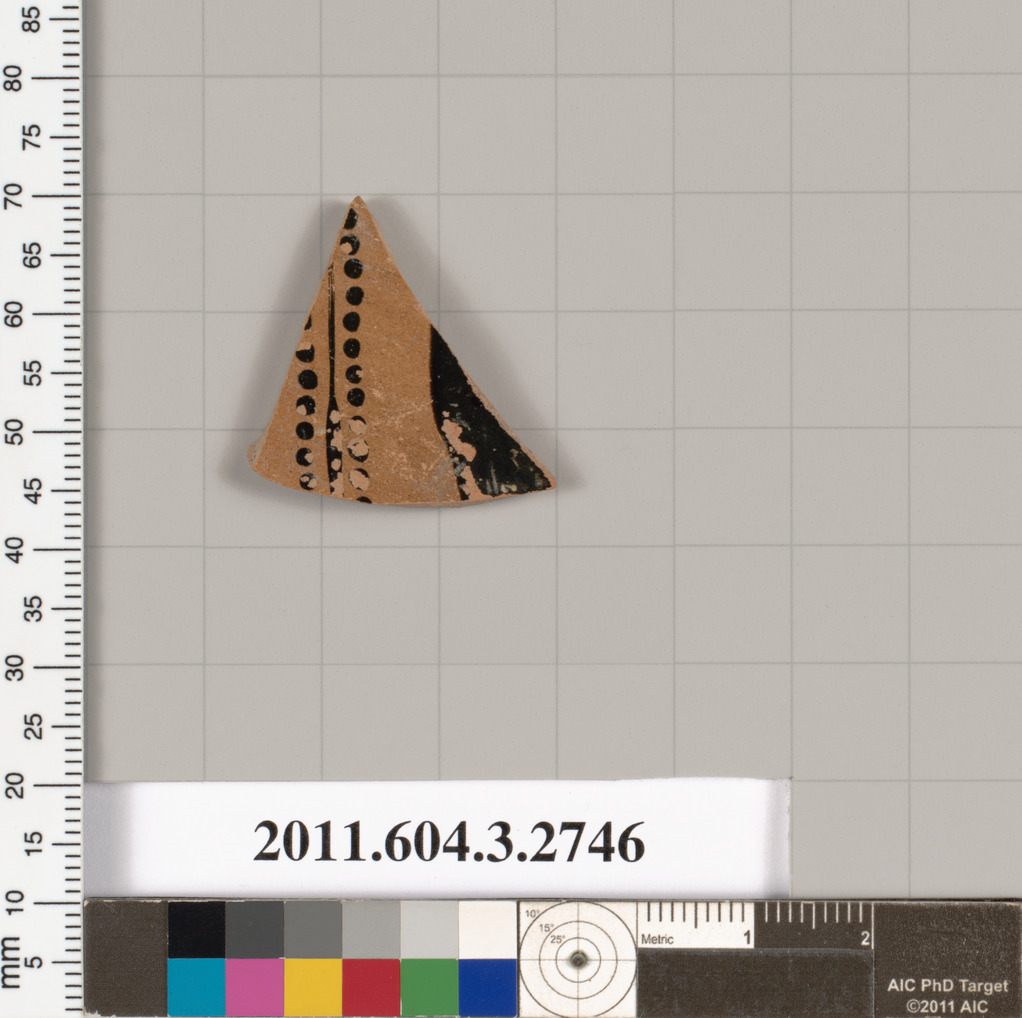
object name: oinochoe or olpe fragment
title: Terracotta fragment of an oinochoe (jug) or olpe (jug)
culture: greek, attic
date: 520-500 BCE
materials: terracotta